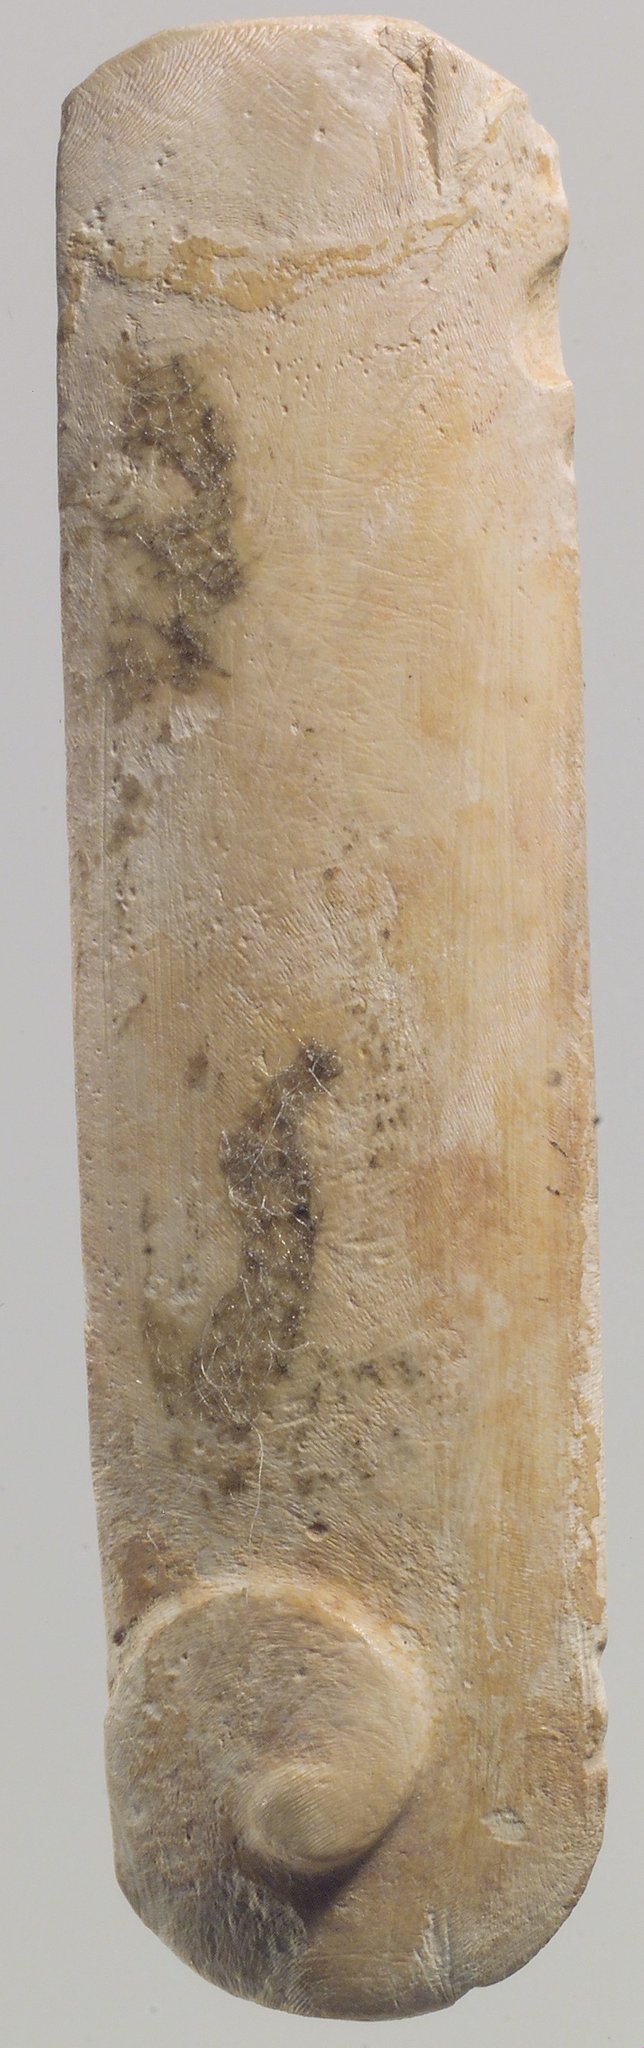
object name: inlay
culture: sumerian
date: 2900-2350 BCE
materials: shell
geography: mesopotamia